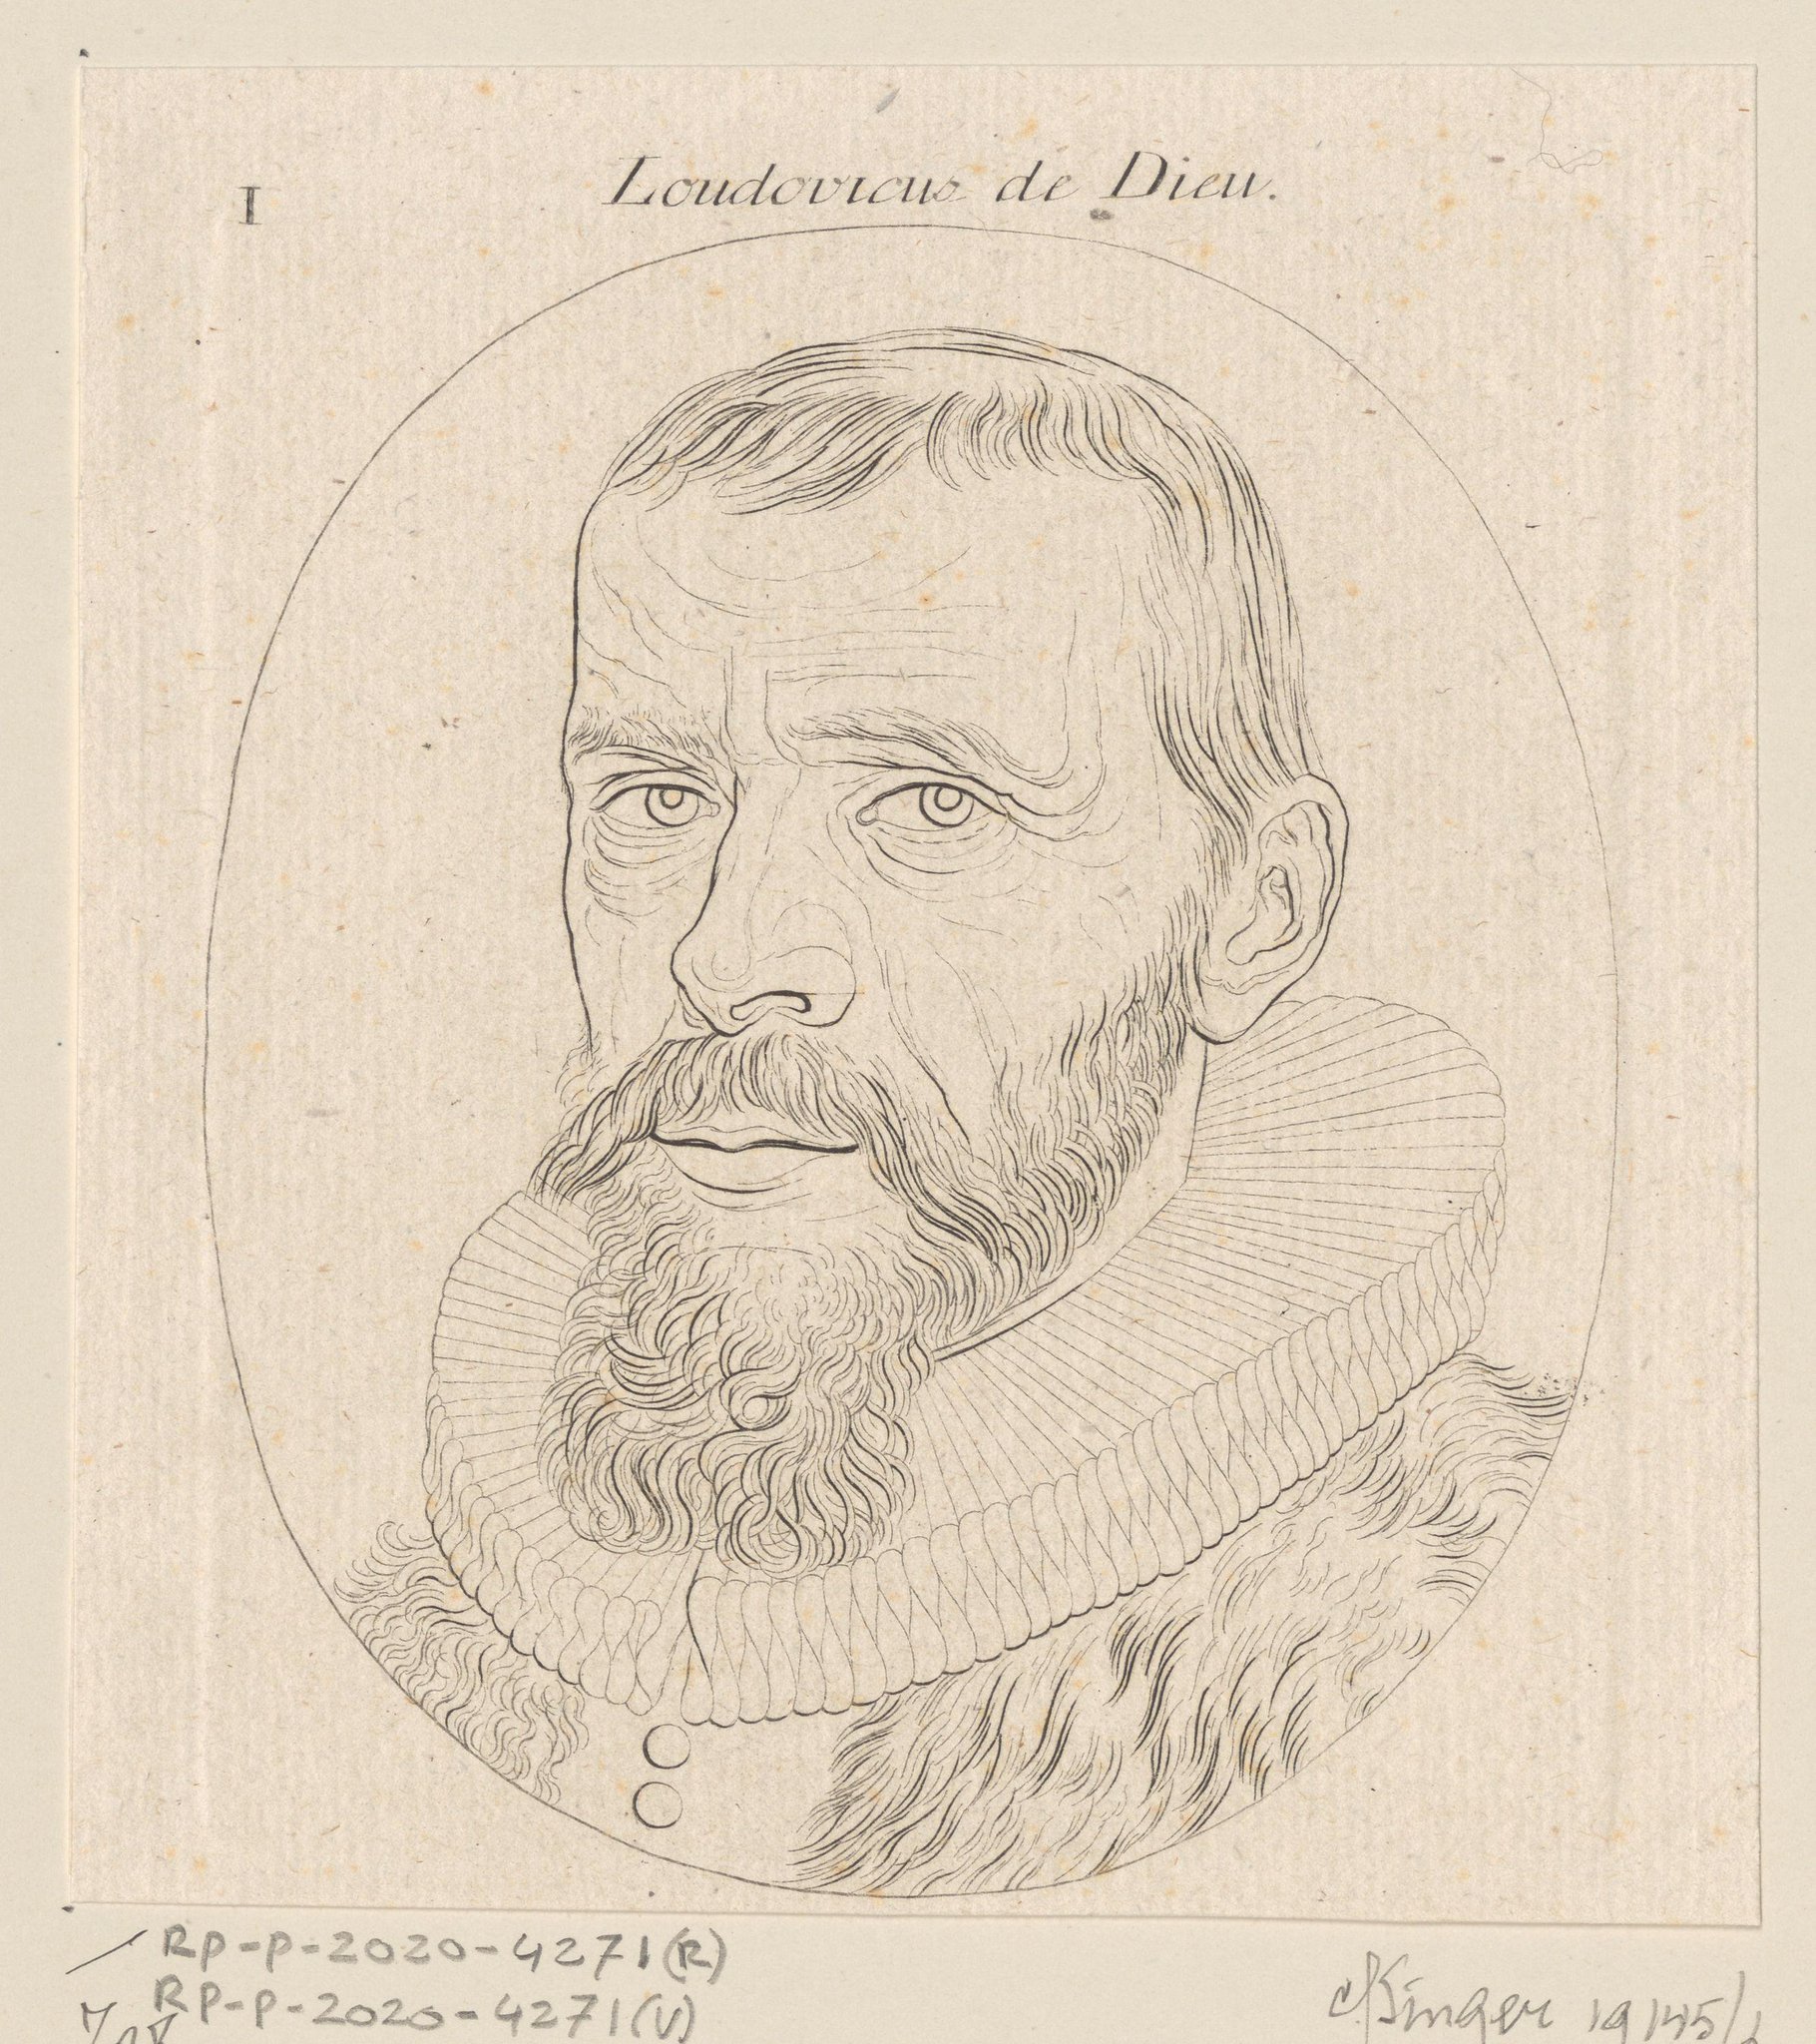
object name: print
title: Portret van Lodewijk de Dieu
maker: Anonymous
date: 1700-1799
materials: paper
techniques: etching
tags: flushing, theologian, historical persons